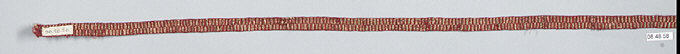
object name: passementerie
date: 1830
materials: metal thread